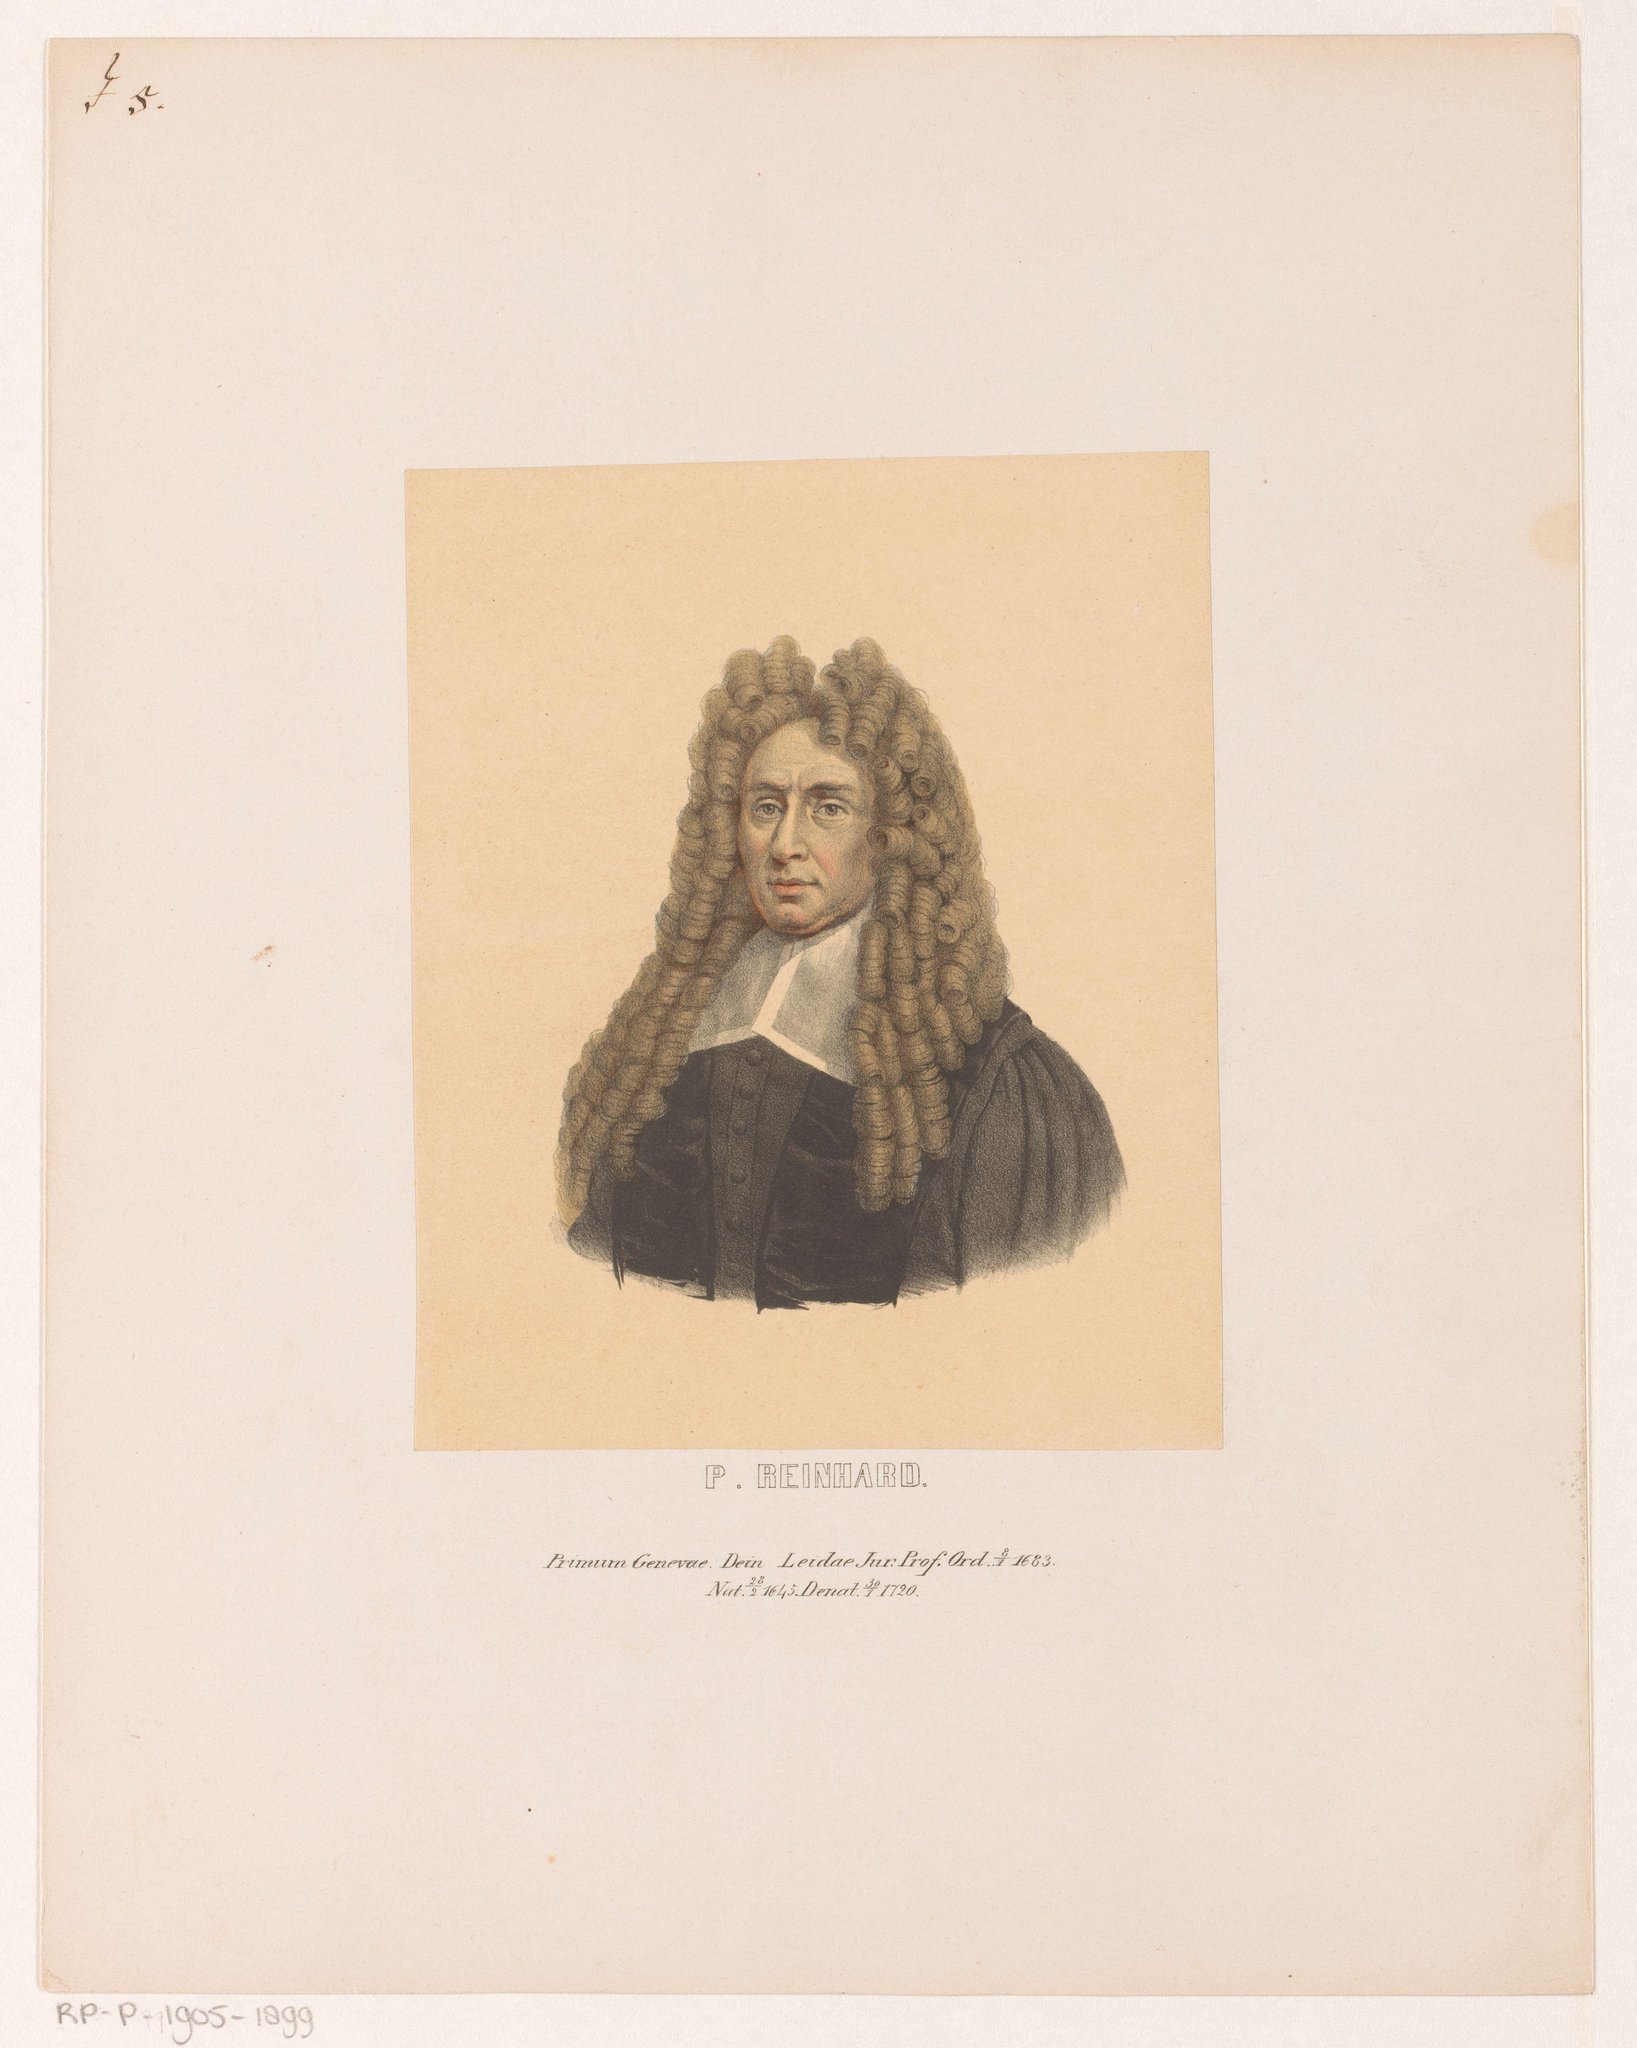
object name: print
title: C.J.C. Reuvens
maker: leendert springer (i)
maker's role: draughtsman, painter, print maker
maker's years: 1789-1871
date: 1850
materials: paper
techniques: lithograph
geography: leiden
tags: the hague, rotterdam, historical persons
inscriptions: collector's mark: Lugt 2228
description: Prent uit: Springer, Leendert. Galerij van hoogleeraren aan de Hoogeschool te Leijden, naar de oorspronkelijke afbeeldsels op de Senaat-zaal aldaar berustende. Leiden: Springer, Leendert., s.a. [circa 1850].